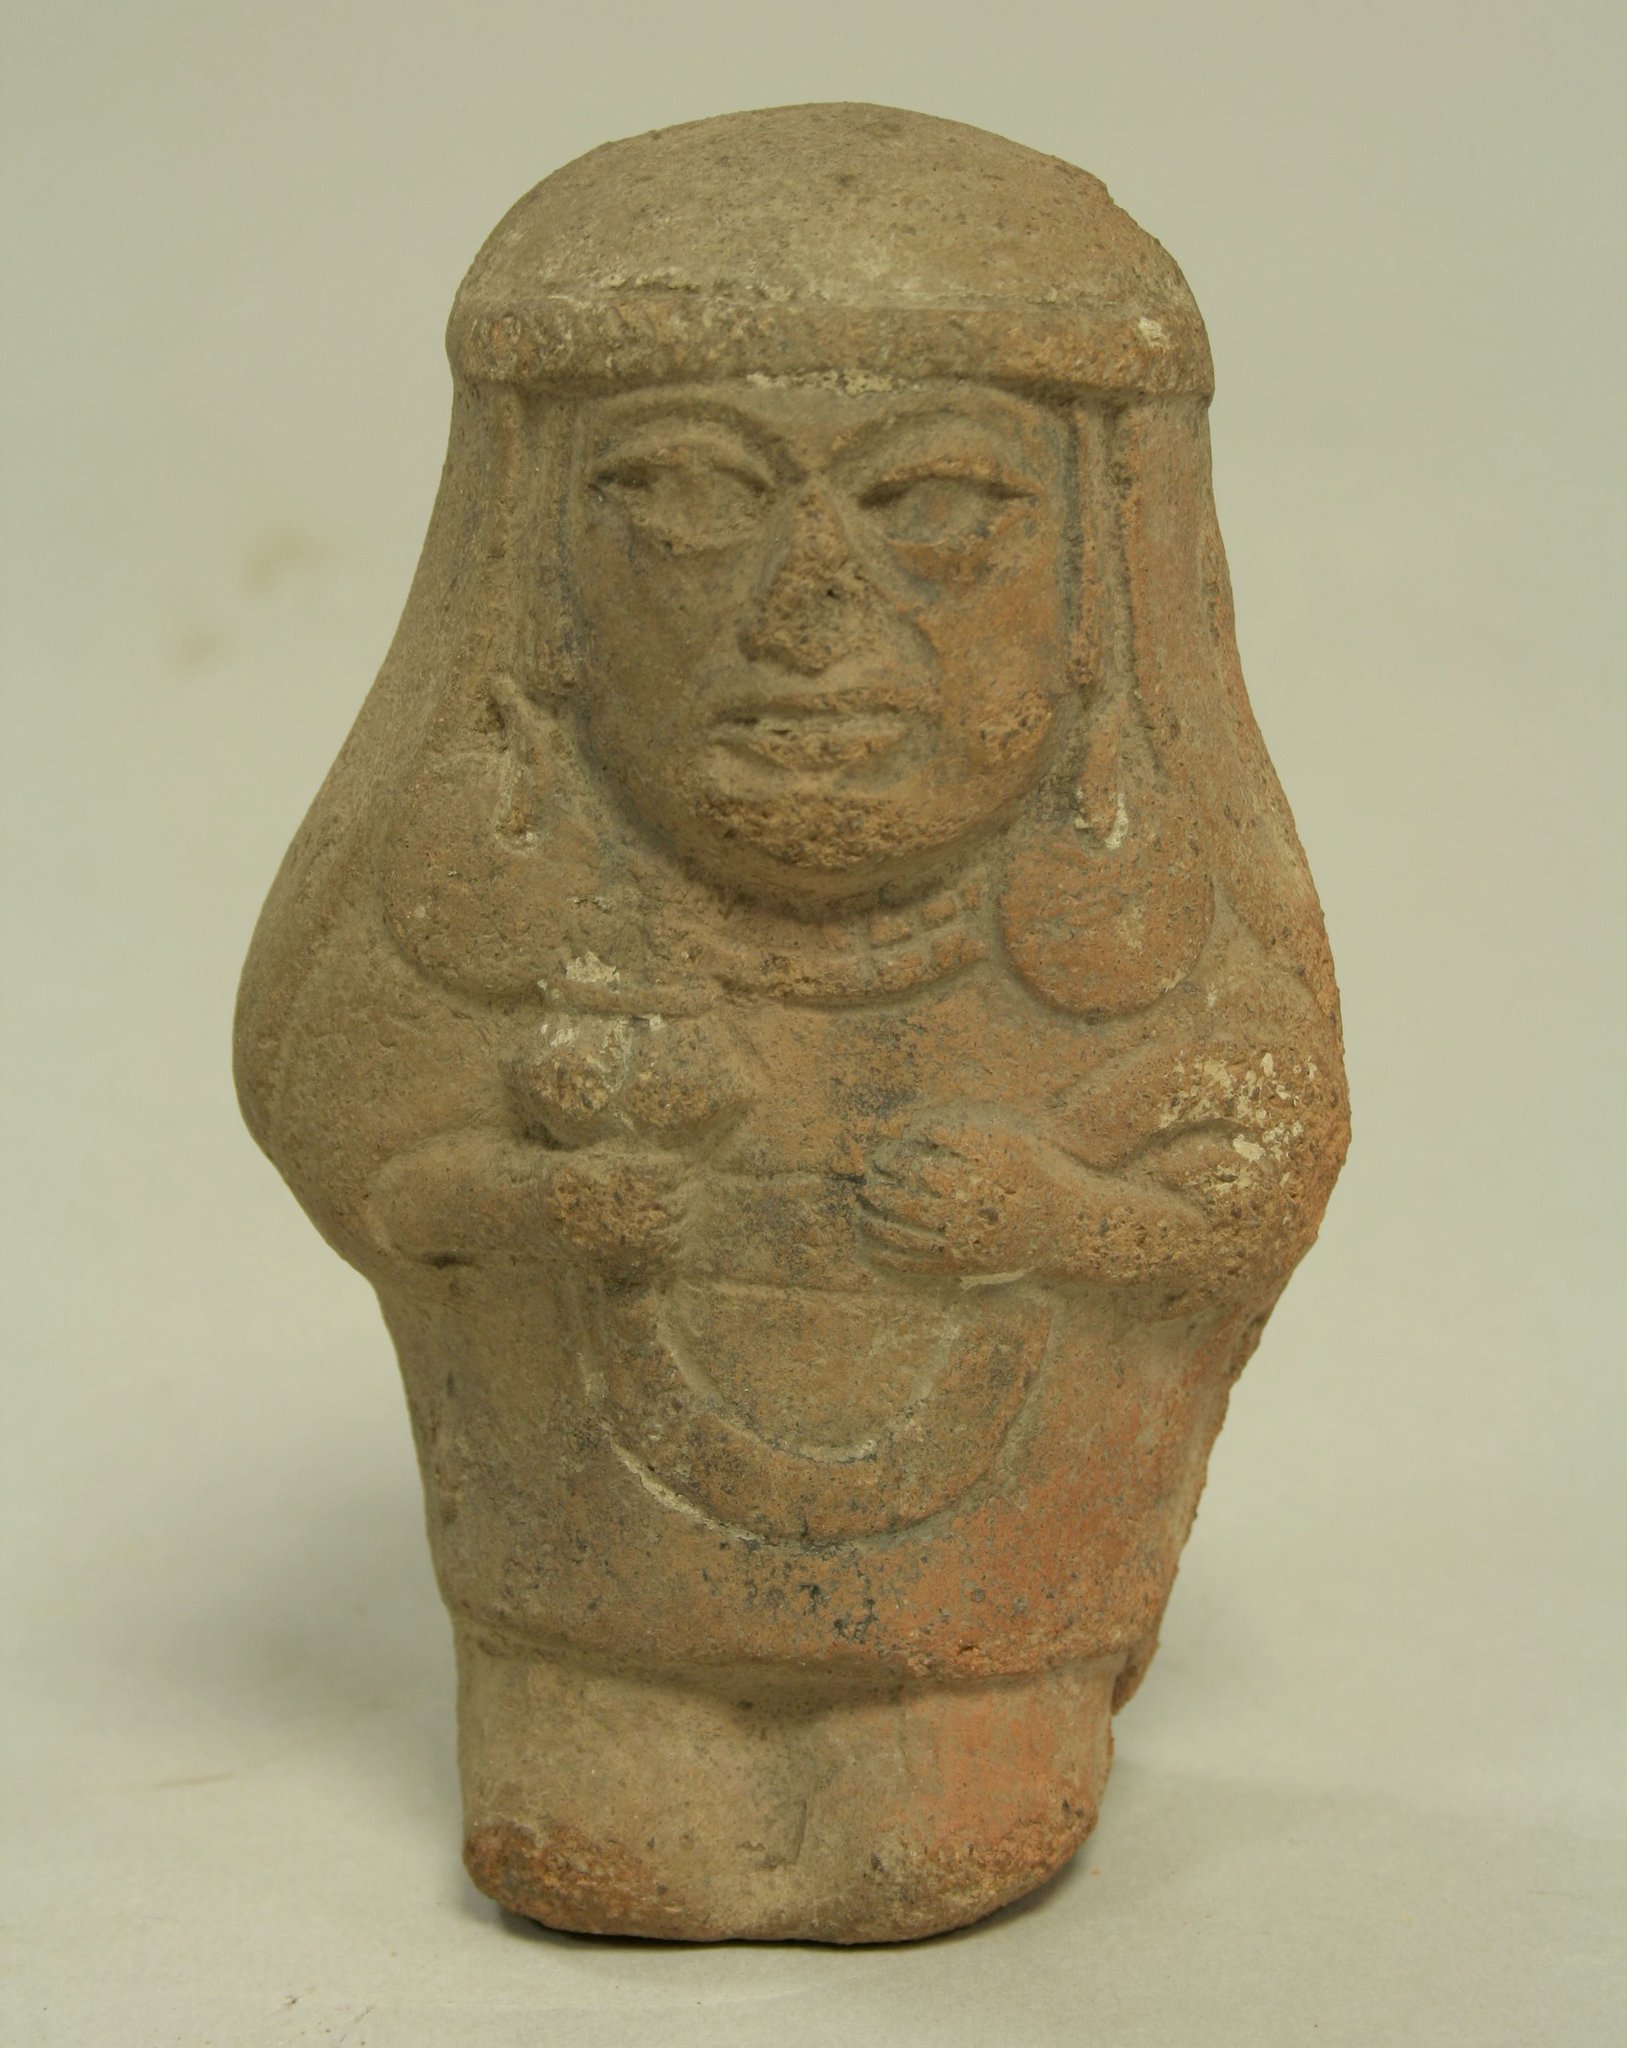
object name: figure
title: Standing Ceramic Figure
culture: moche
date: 201-500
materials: ceramic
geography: peru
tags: human figures